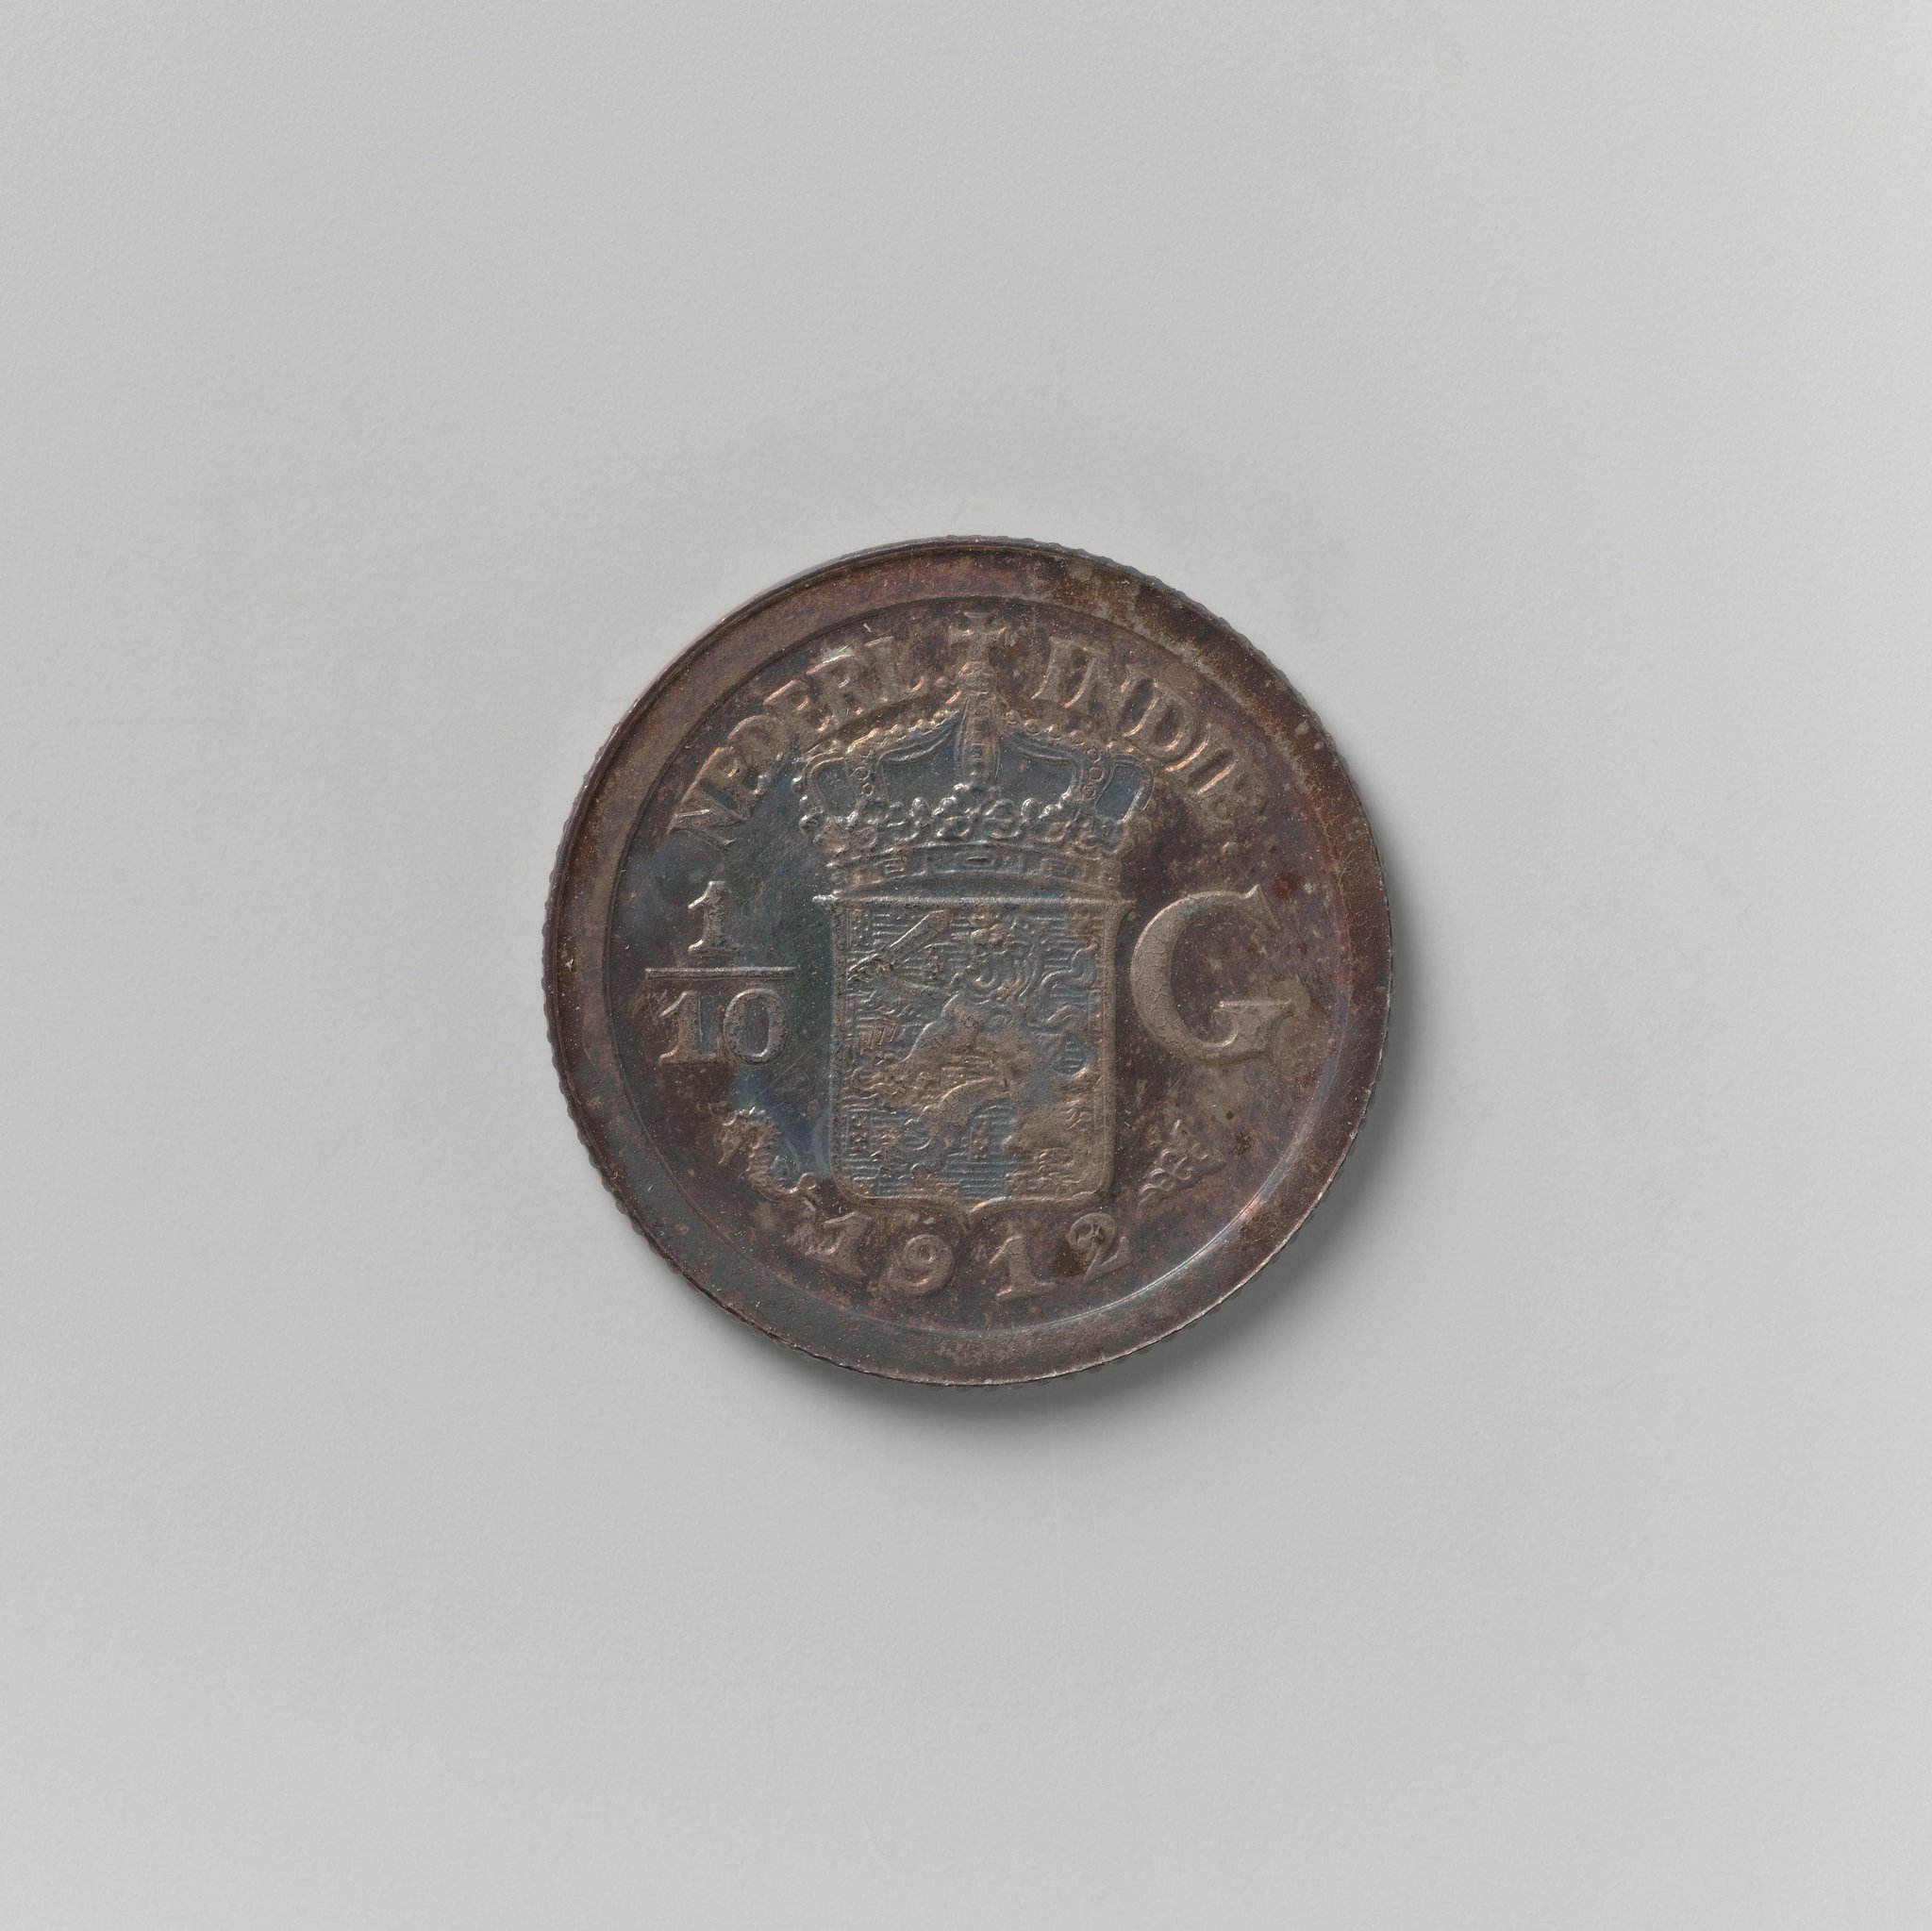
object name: coin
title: Nederlands Indië,1/10 gulden,1912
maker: wilhelmina of the netherlands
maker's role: print maker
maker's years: 1880-1962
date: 1912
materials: copper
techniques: striking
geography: utrecht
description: Zilveren munt. Voorzijde: tussen waarde-aanduiding 1/10 G gekroond rijkswapenschild. Boven kroon landsaanduiding en onder wapenschild jaartal. Keerzijde: tweeregelig Maleis opschrift in Arabische tekens, waaromheen omschrift in het Javaans. Kartelrand.